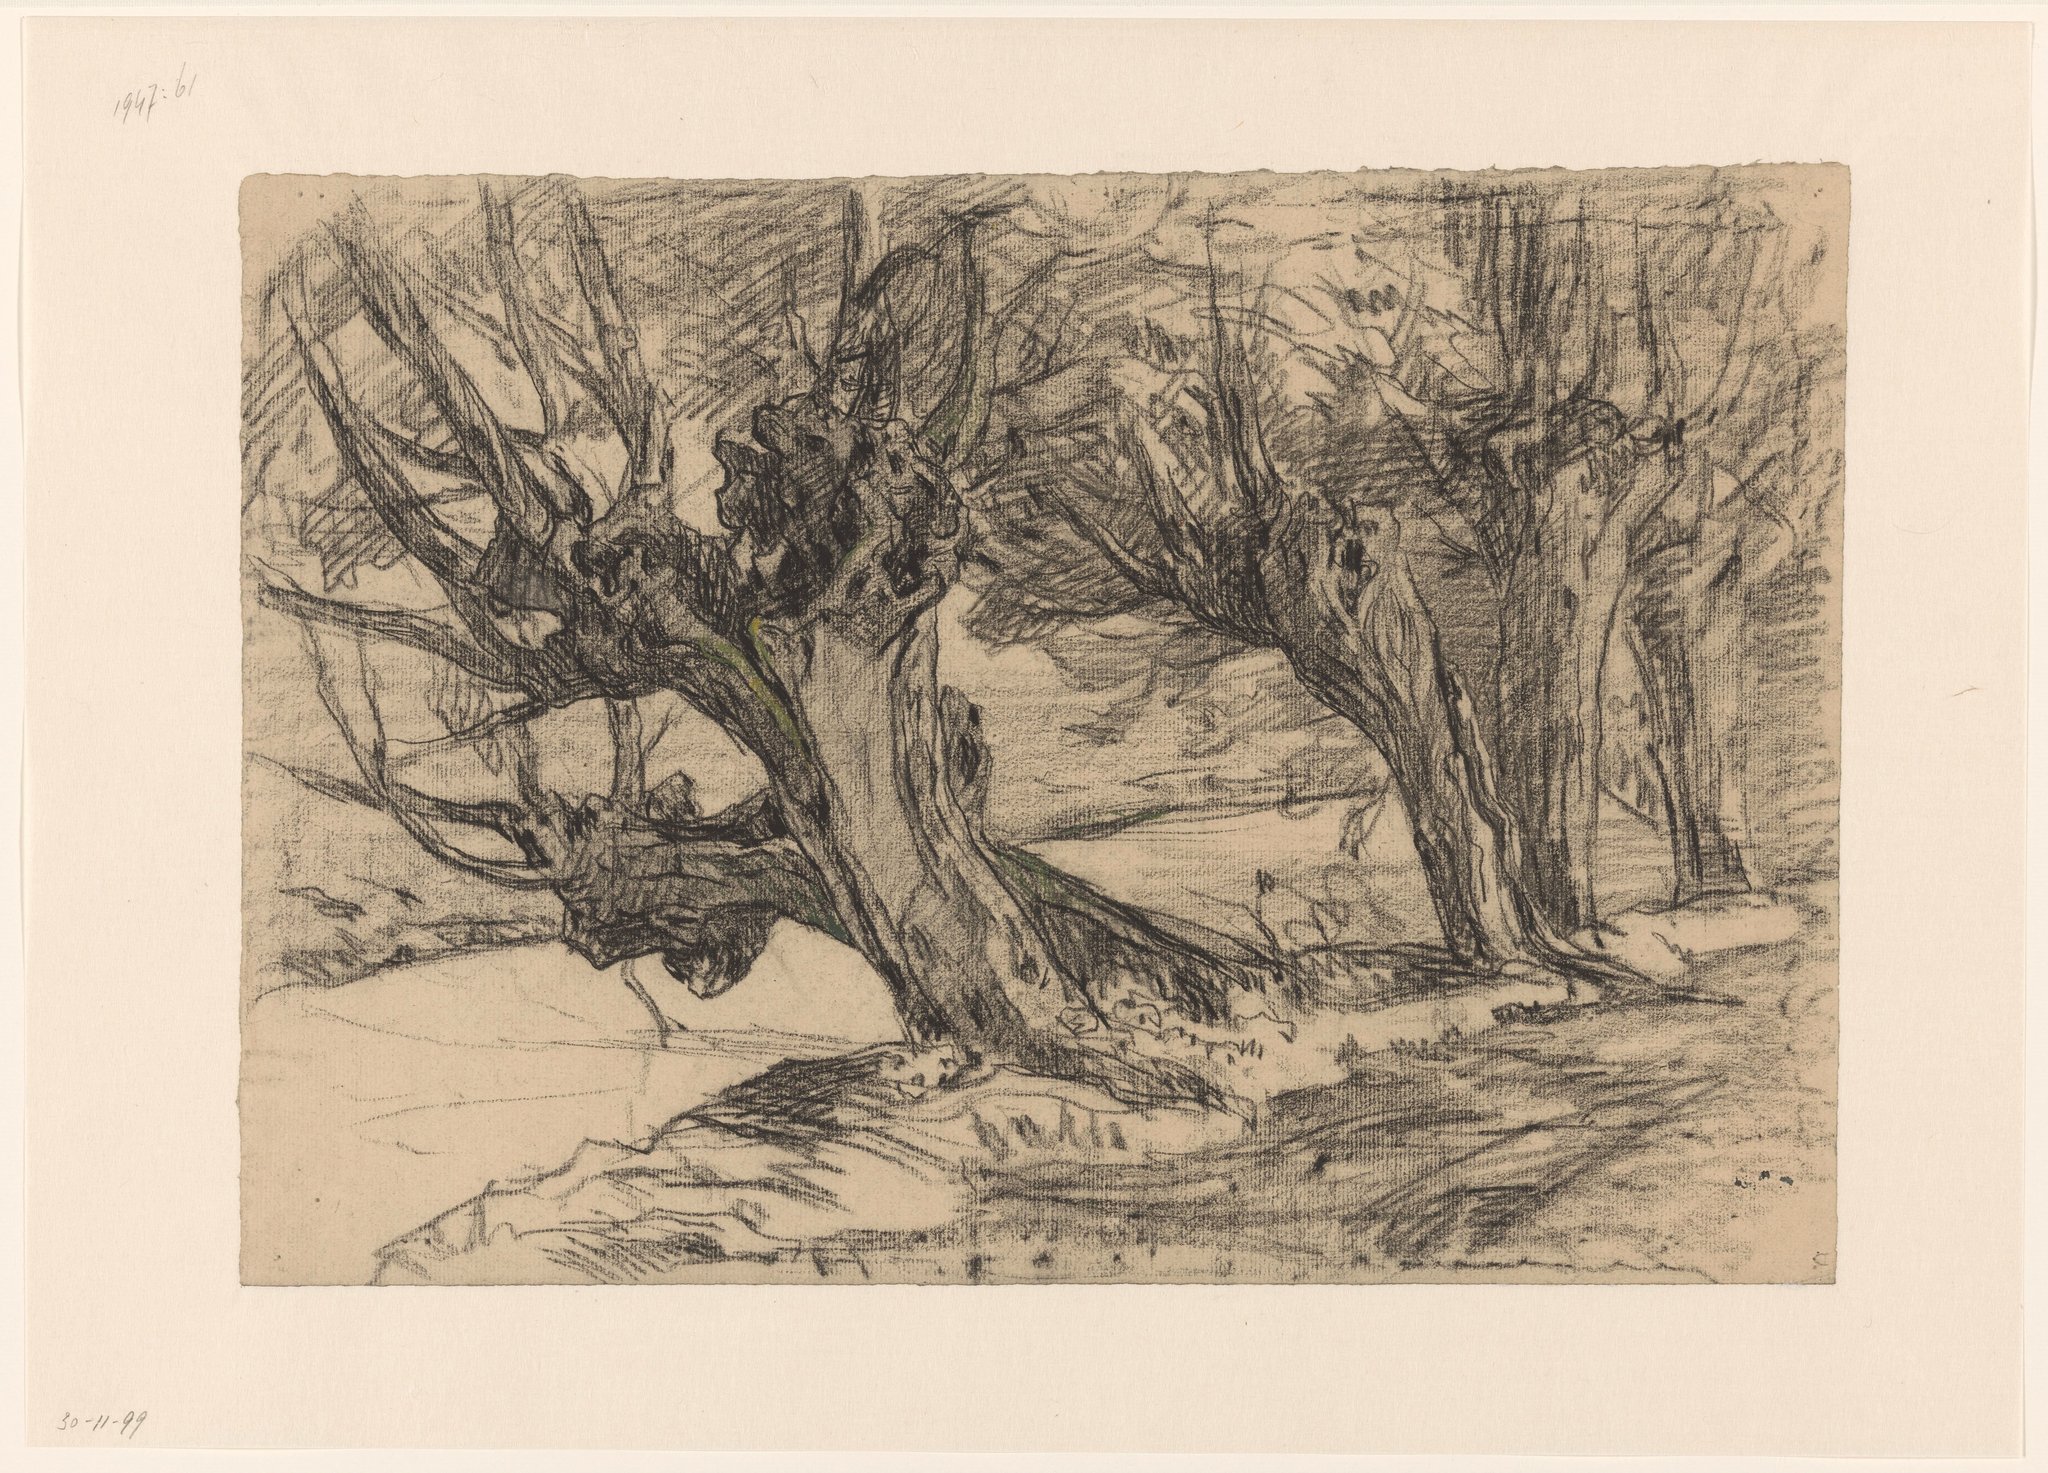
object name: drawing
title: Knotwilgen aan een sloot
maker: wilhelmus johannes steenhoff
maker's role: draughtsman, print maker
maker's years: 1863-1932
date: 1873-1932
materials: chalk, paper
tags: trees: pollard willow